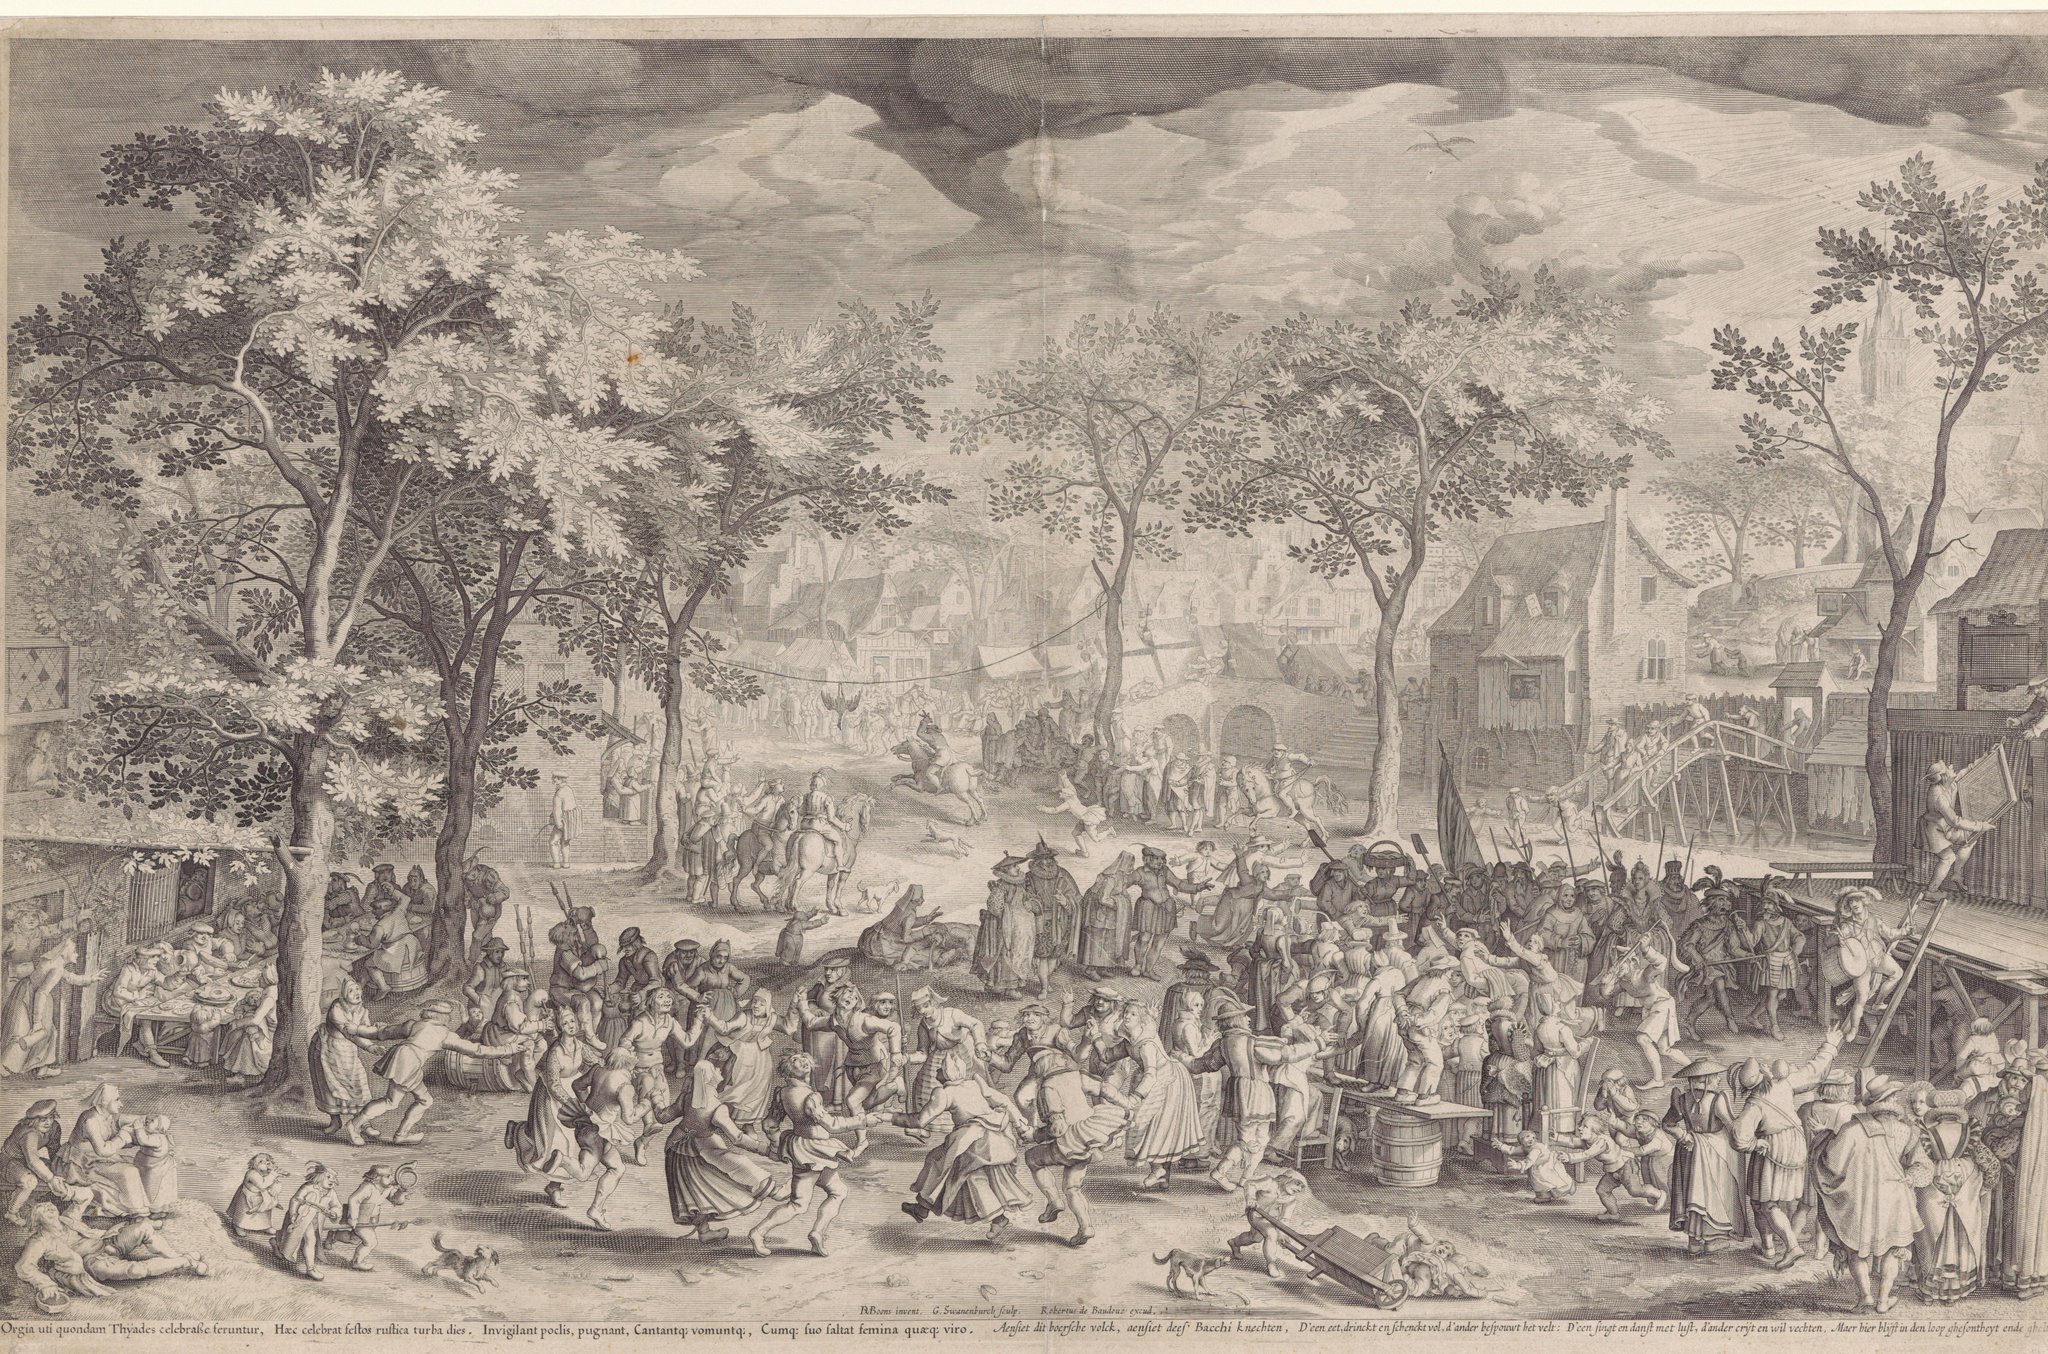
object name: print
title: Dorpskermis, ca. 1610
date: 1595-1612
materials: paper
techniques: engraving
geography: leiden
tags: folk dancing (men and women together), performance in the open air (pleasure fair), pleasure fair and circus, 'pull-the-goose'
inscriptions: collector's mark: Lugt 2228, collector's mark: Lugt 2529, collector's mark: Lugt 1606, collector's mark: ‘A 86’ Lugt 234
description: Grote voorstelling van de kermis in een dorp. Rechts wordt een toneel opgebouwd voor een toneelvoorstelling door een rederijkersgezelschap en wordt er voor het verzamelde publiek een klucht opgevoerd. De tamboer staat op de ladder terwijl het rederijkersblazoen boven het toneel wordt gehangen. Met boeren en elegante burgers. Verder dansende boeren, een maaltijd voor een herberg, muziek maken, drinken, spelende kinderen en overgeven. Op de achtergrond een wedstrijd gansrijden of vogelsnijden. Met onderschrift in het Latijn en Nederlands.